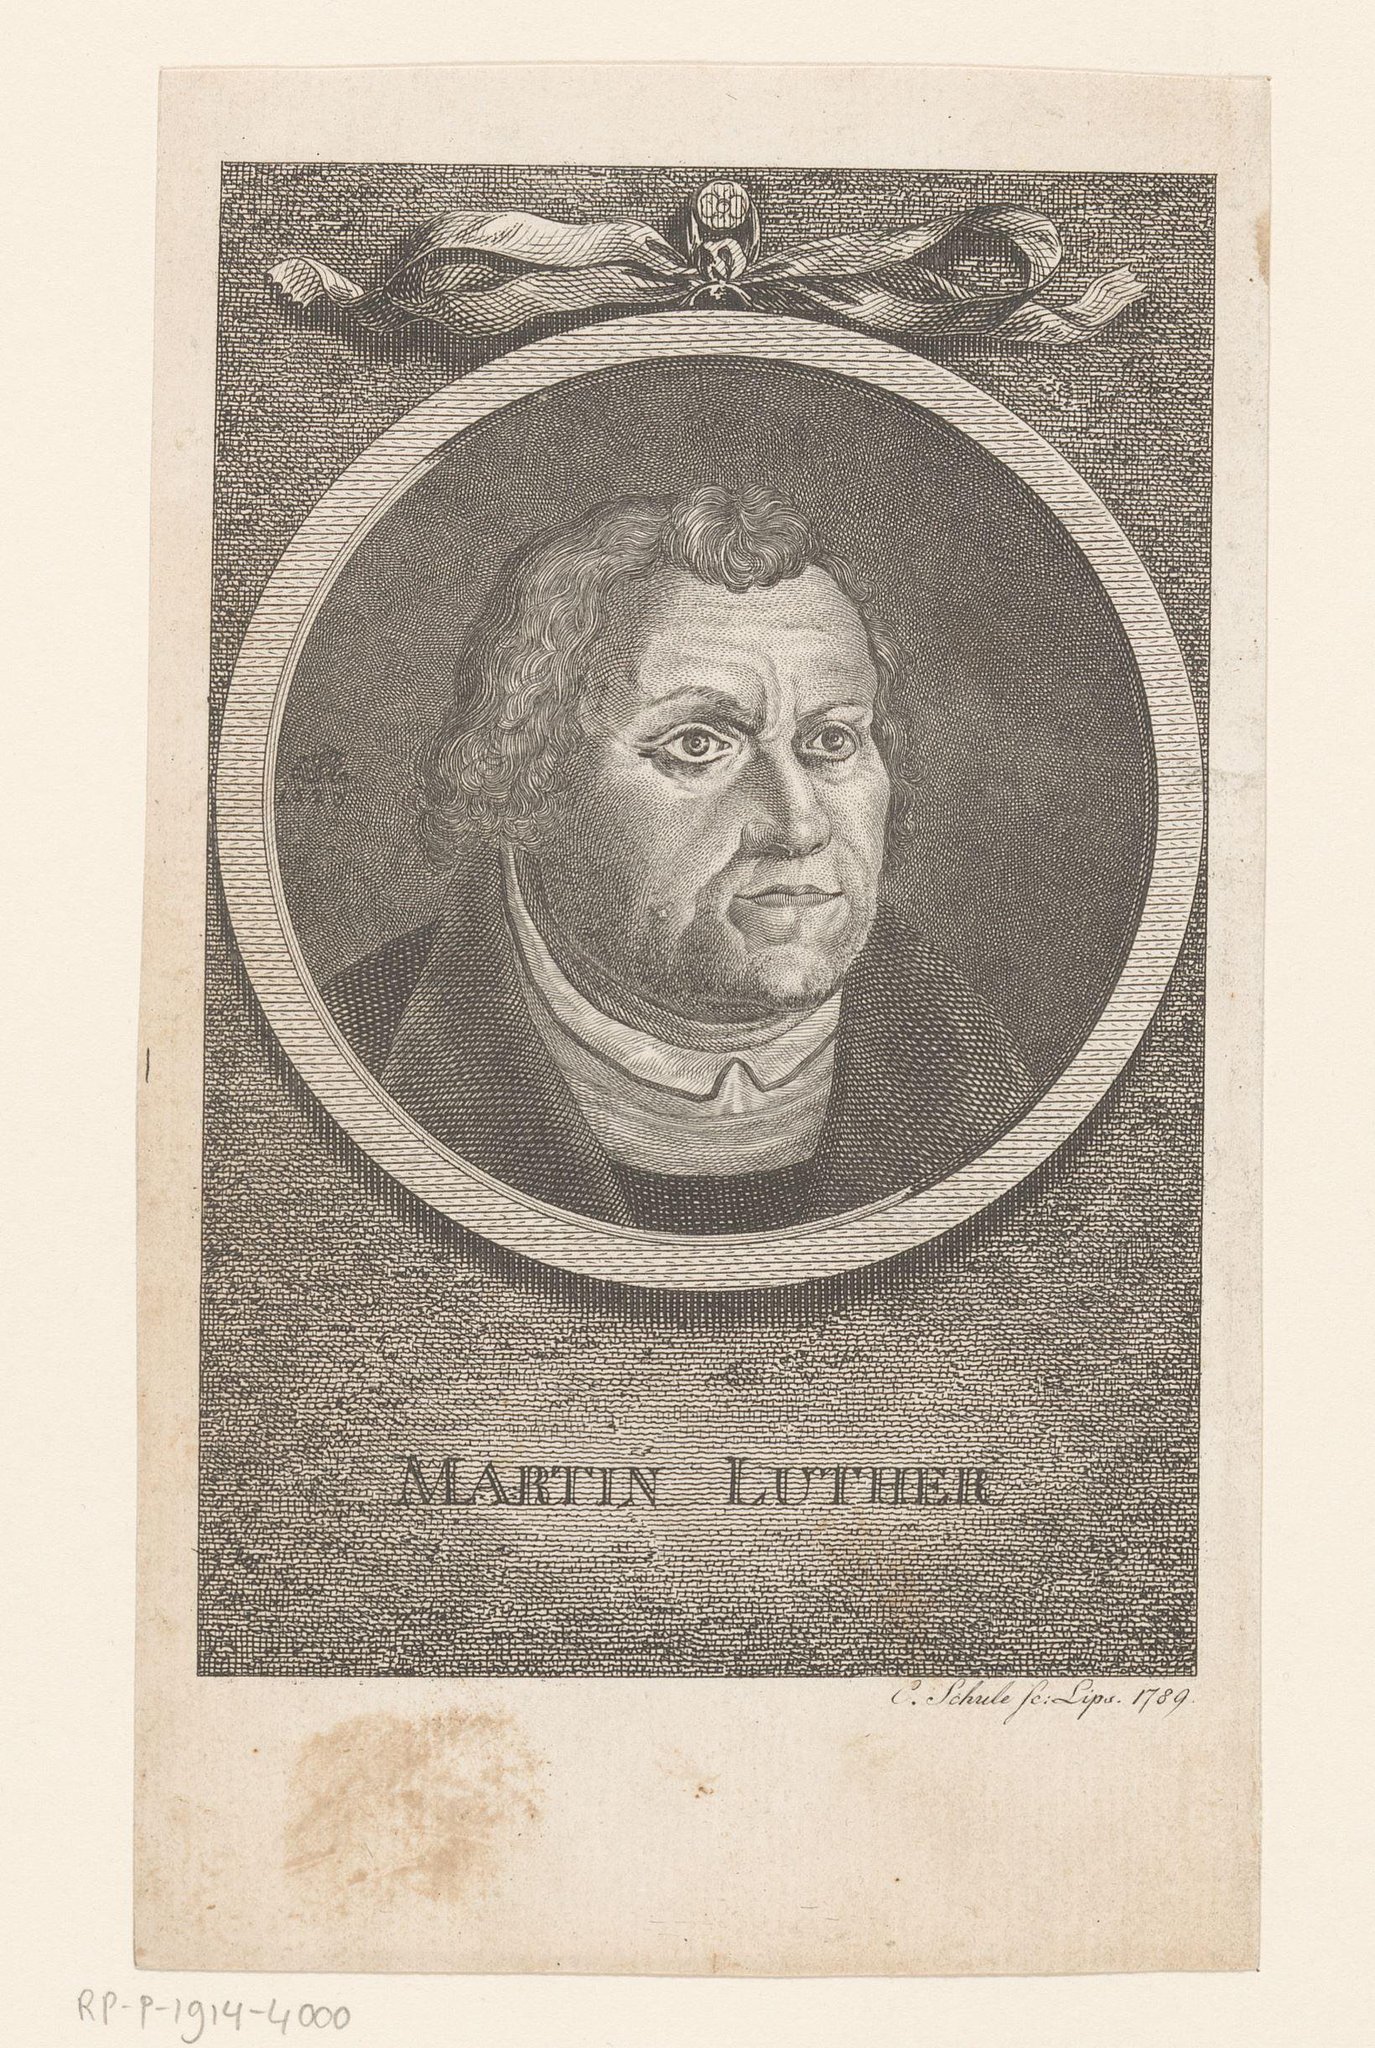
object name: print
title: Martin Luther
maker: christian schule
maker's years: 1764-1816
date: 1789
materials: paper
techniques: engraving, etching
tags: priest, martin luther, theologian, historical persons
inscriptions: collector's mark: Lugt 2228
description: Portret van de Duitse lutherse hervormer Martin Luther.